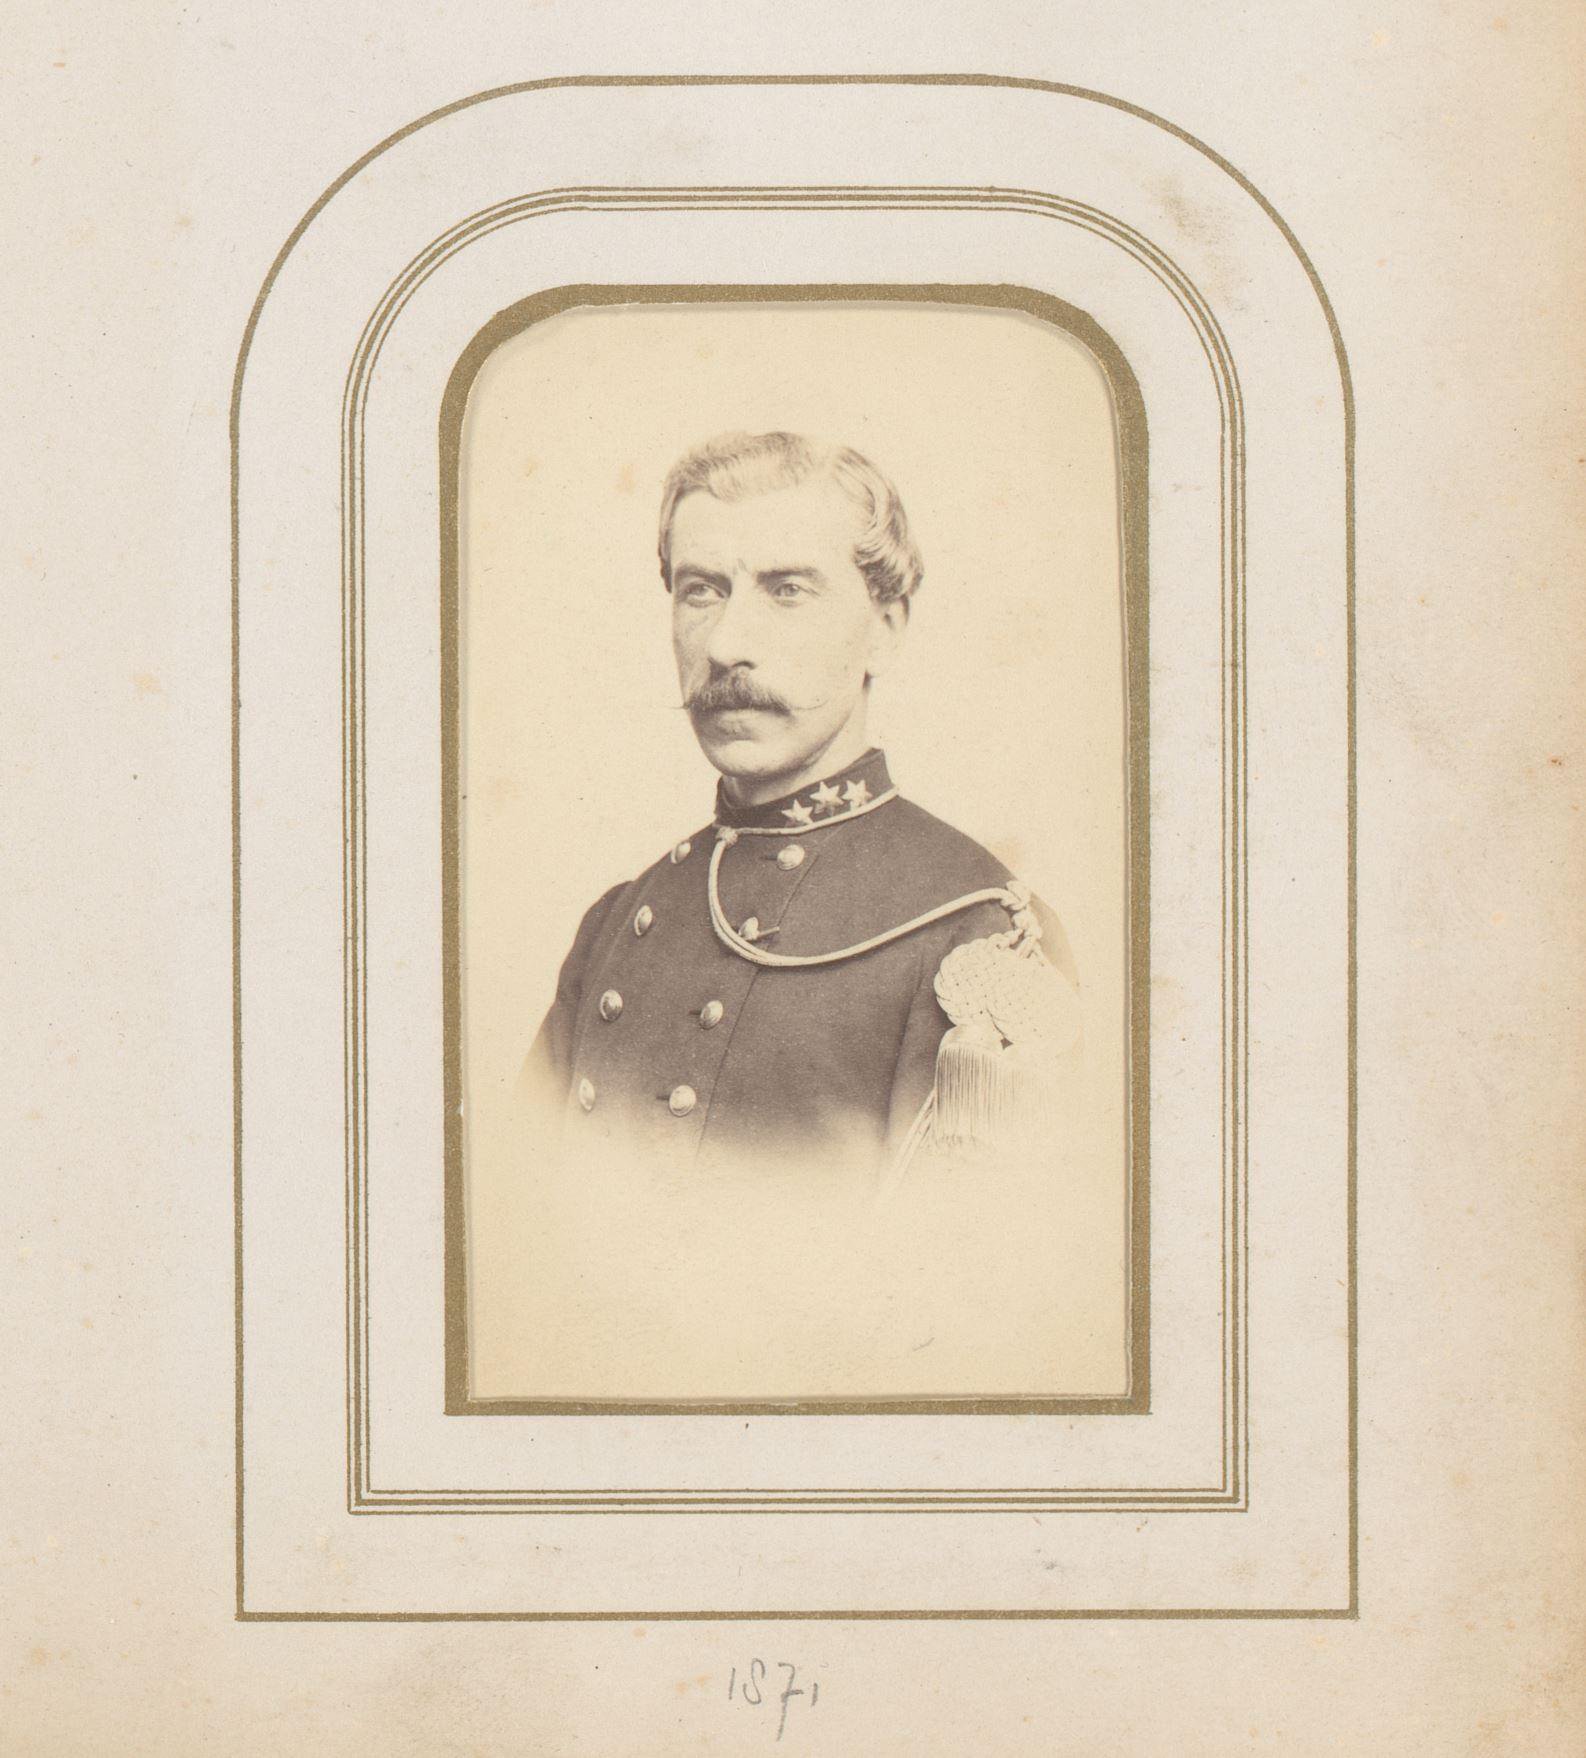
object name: photograph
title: Portret van een man met snor in uniform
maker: albert delabarre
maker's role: musician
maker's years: 1809-1885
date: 1871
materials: cardboard, photographic support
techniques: albumen print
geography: brussels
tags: moustache, historical persons, (military) uniforms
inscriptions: inscription: ‘Photographie Parisienne/ 36, Rue Fossé aux Loups, 36/ (Place de la Monnaie)/ Bruxelles’, number: ‘Souvenir affectueux et [...] à mon major Bruxelles le 1 janv. 1871 [...]’, date: ‘1871’